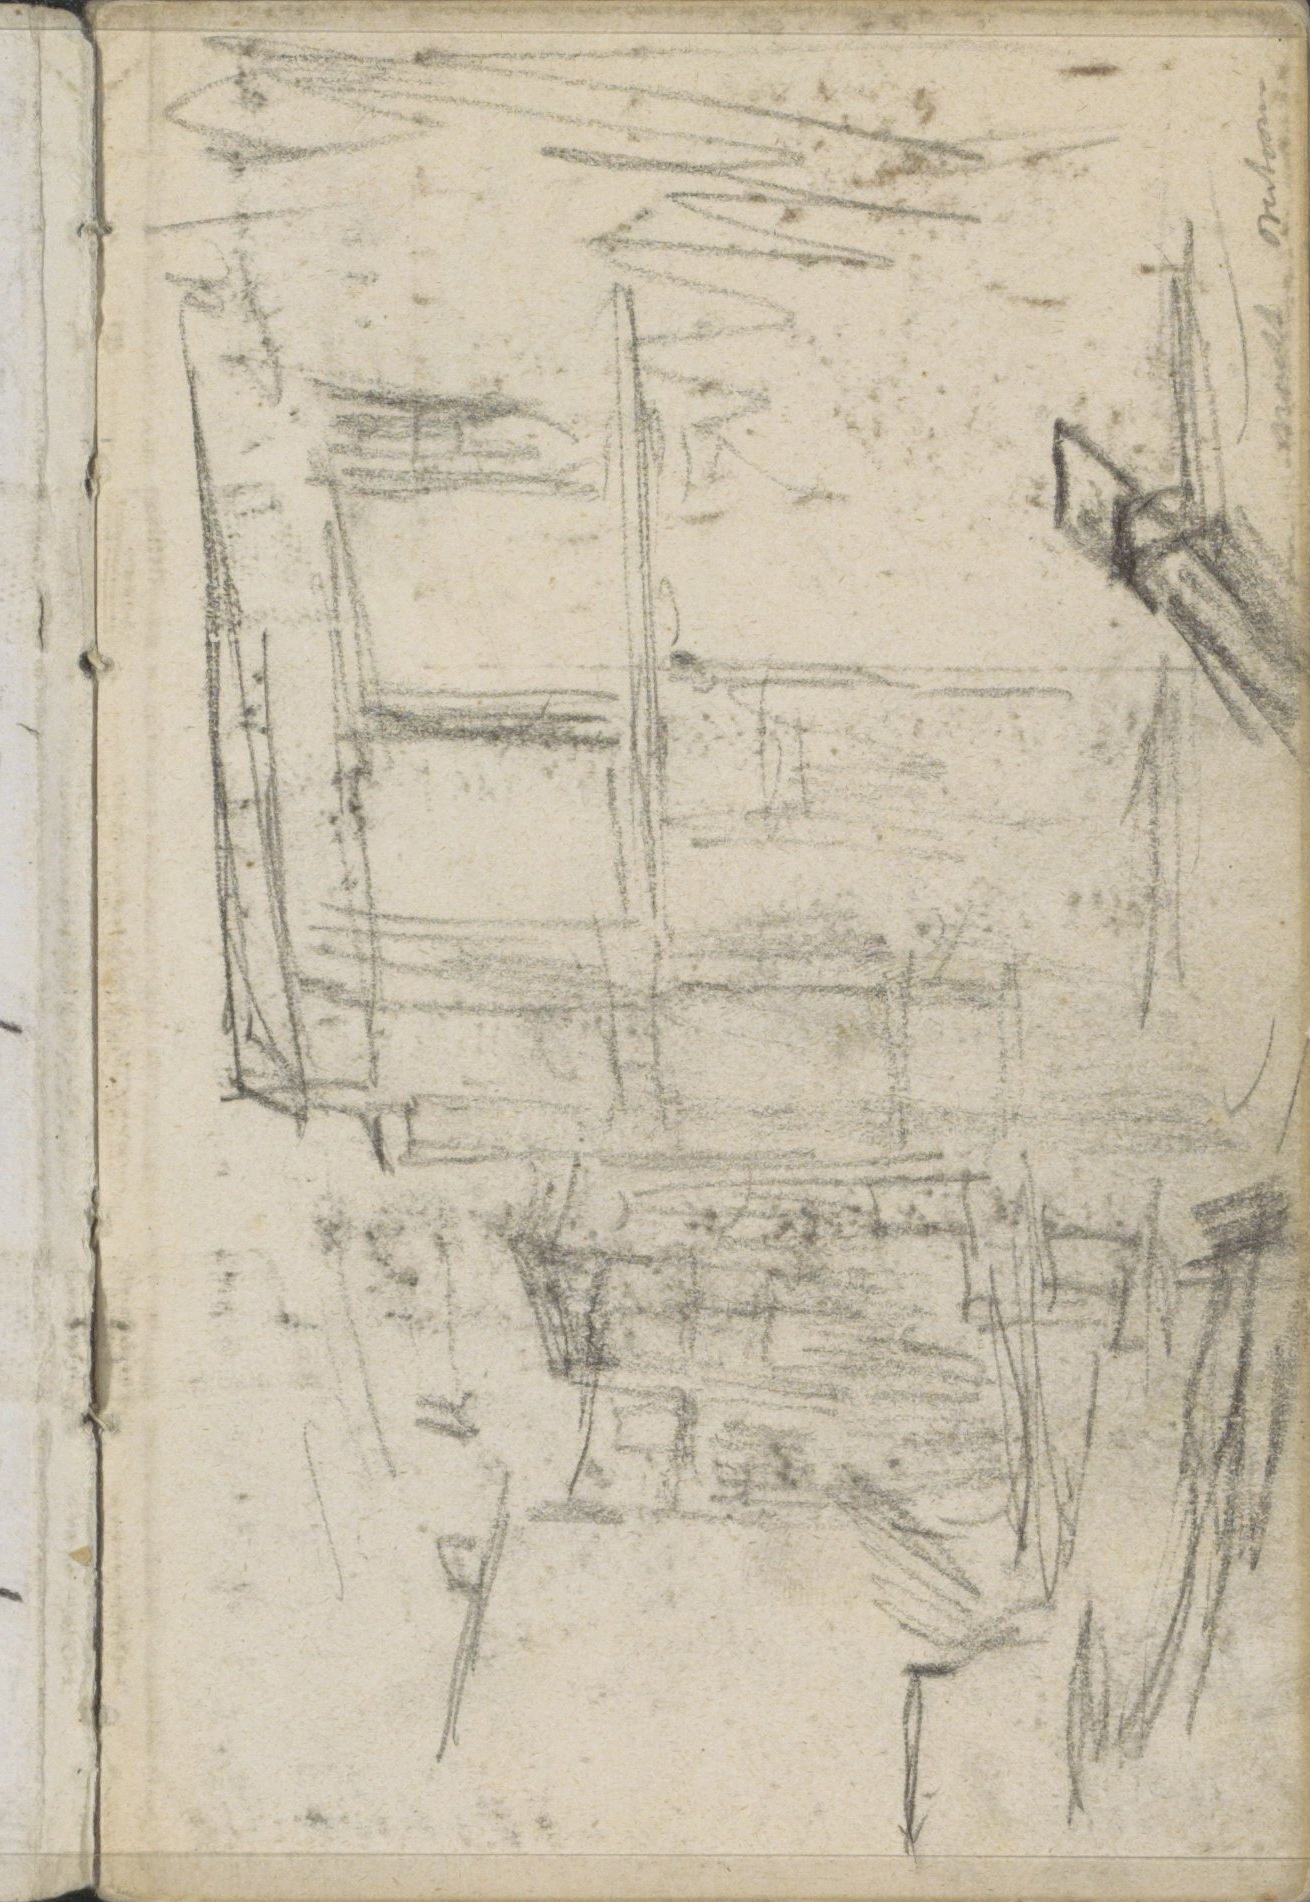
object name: sketchbook leaf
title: Gezicht op de Overtoom te Amsterdam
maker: george hendrik breitner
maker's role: draughtsman, painter, print maker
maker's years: 1857-1923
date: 1907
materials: chalk, paper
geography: amsterdam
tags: urban housing, canals, waters (in city)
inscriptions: annotation: ‘nacht Overtoom’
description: Gezicht op de Overtoom te Amsterdam. Pagina 2 uit een schetsboek met 46 bladen vervaardigd in Amsterdam, Rotterdam en Haarlem.